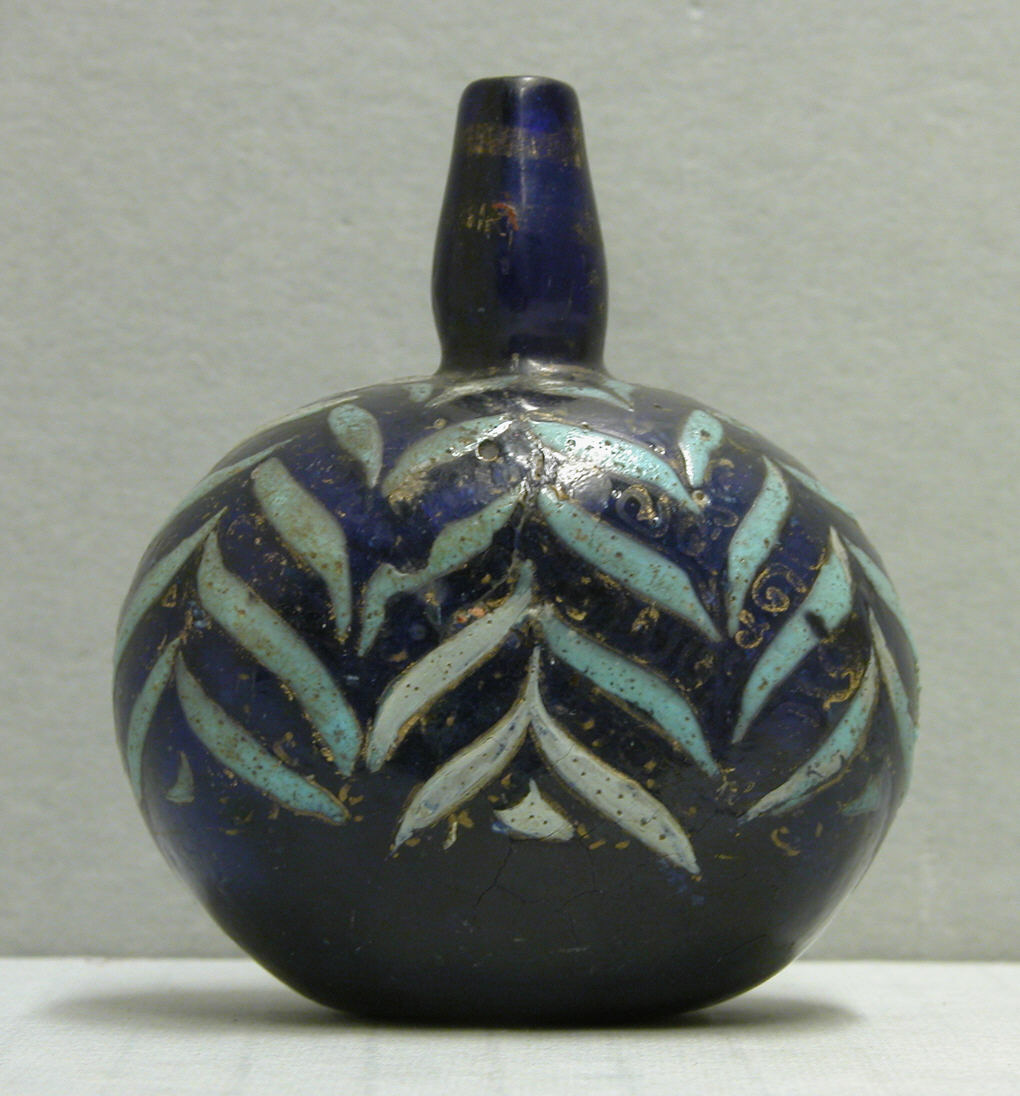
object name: perfume sprinkler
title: Perfume Sprinkler (Qumqum)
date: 1201-1233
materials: glass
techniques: glassblowing, enamel, gilding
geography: syria